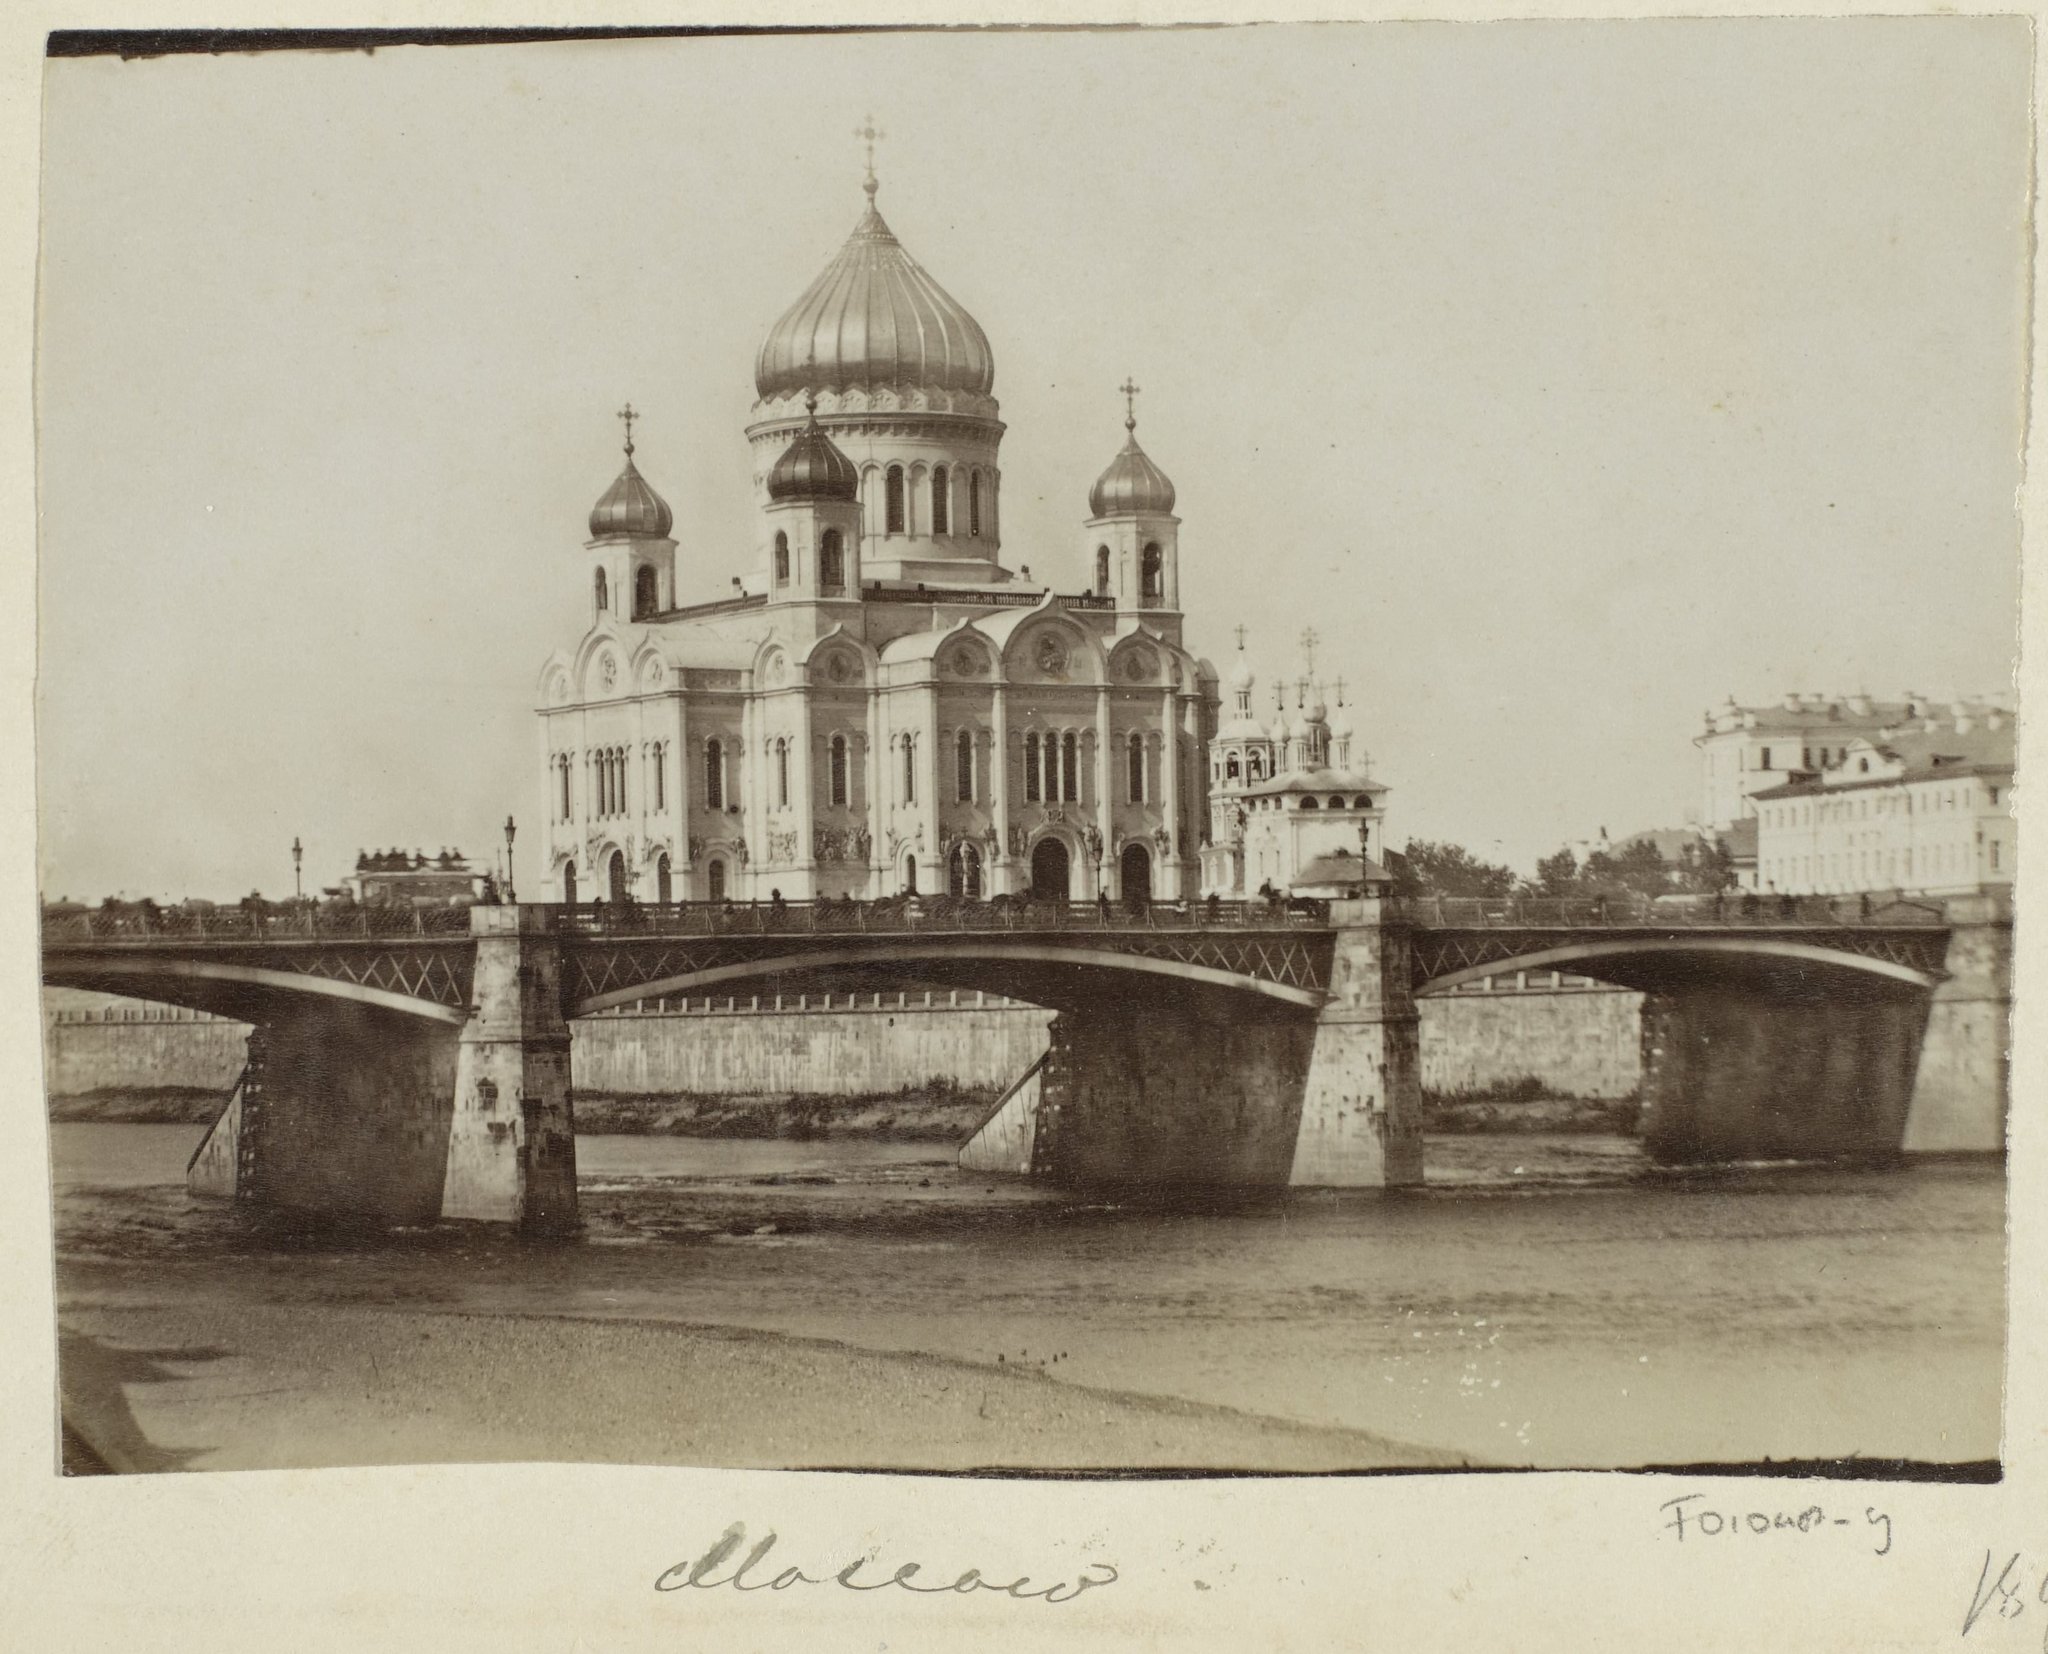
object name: photograph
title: Moscow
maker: Anonymous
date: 1880-1890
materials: paper, photographic support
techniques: albumen print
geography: moscow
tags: russian orthodox church, bridge in city across river, canal, etc.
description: Onderdeel van Reisalbum van H. Dunlop met foto's van bezienswaardigheden in Perzië, Schotland, Duitsland, Rusland, China en Canada.